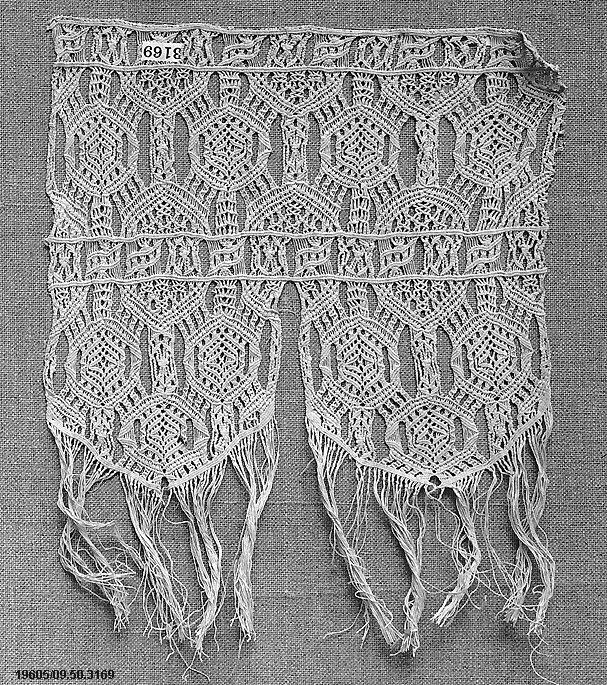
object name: fragment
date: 1601-1700